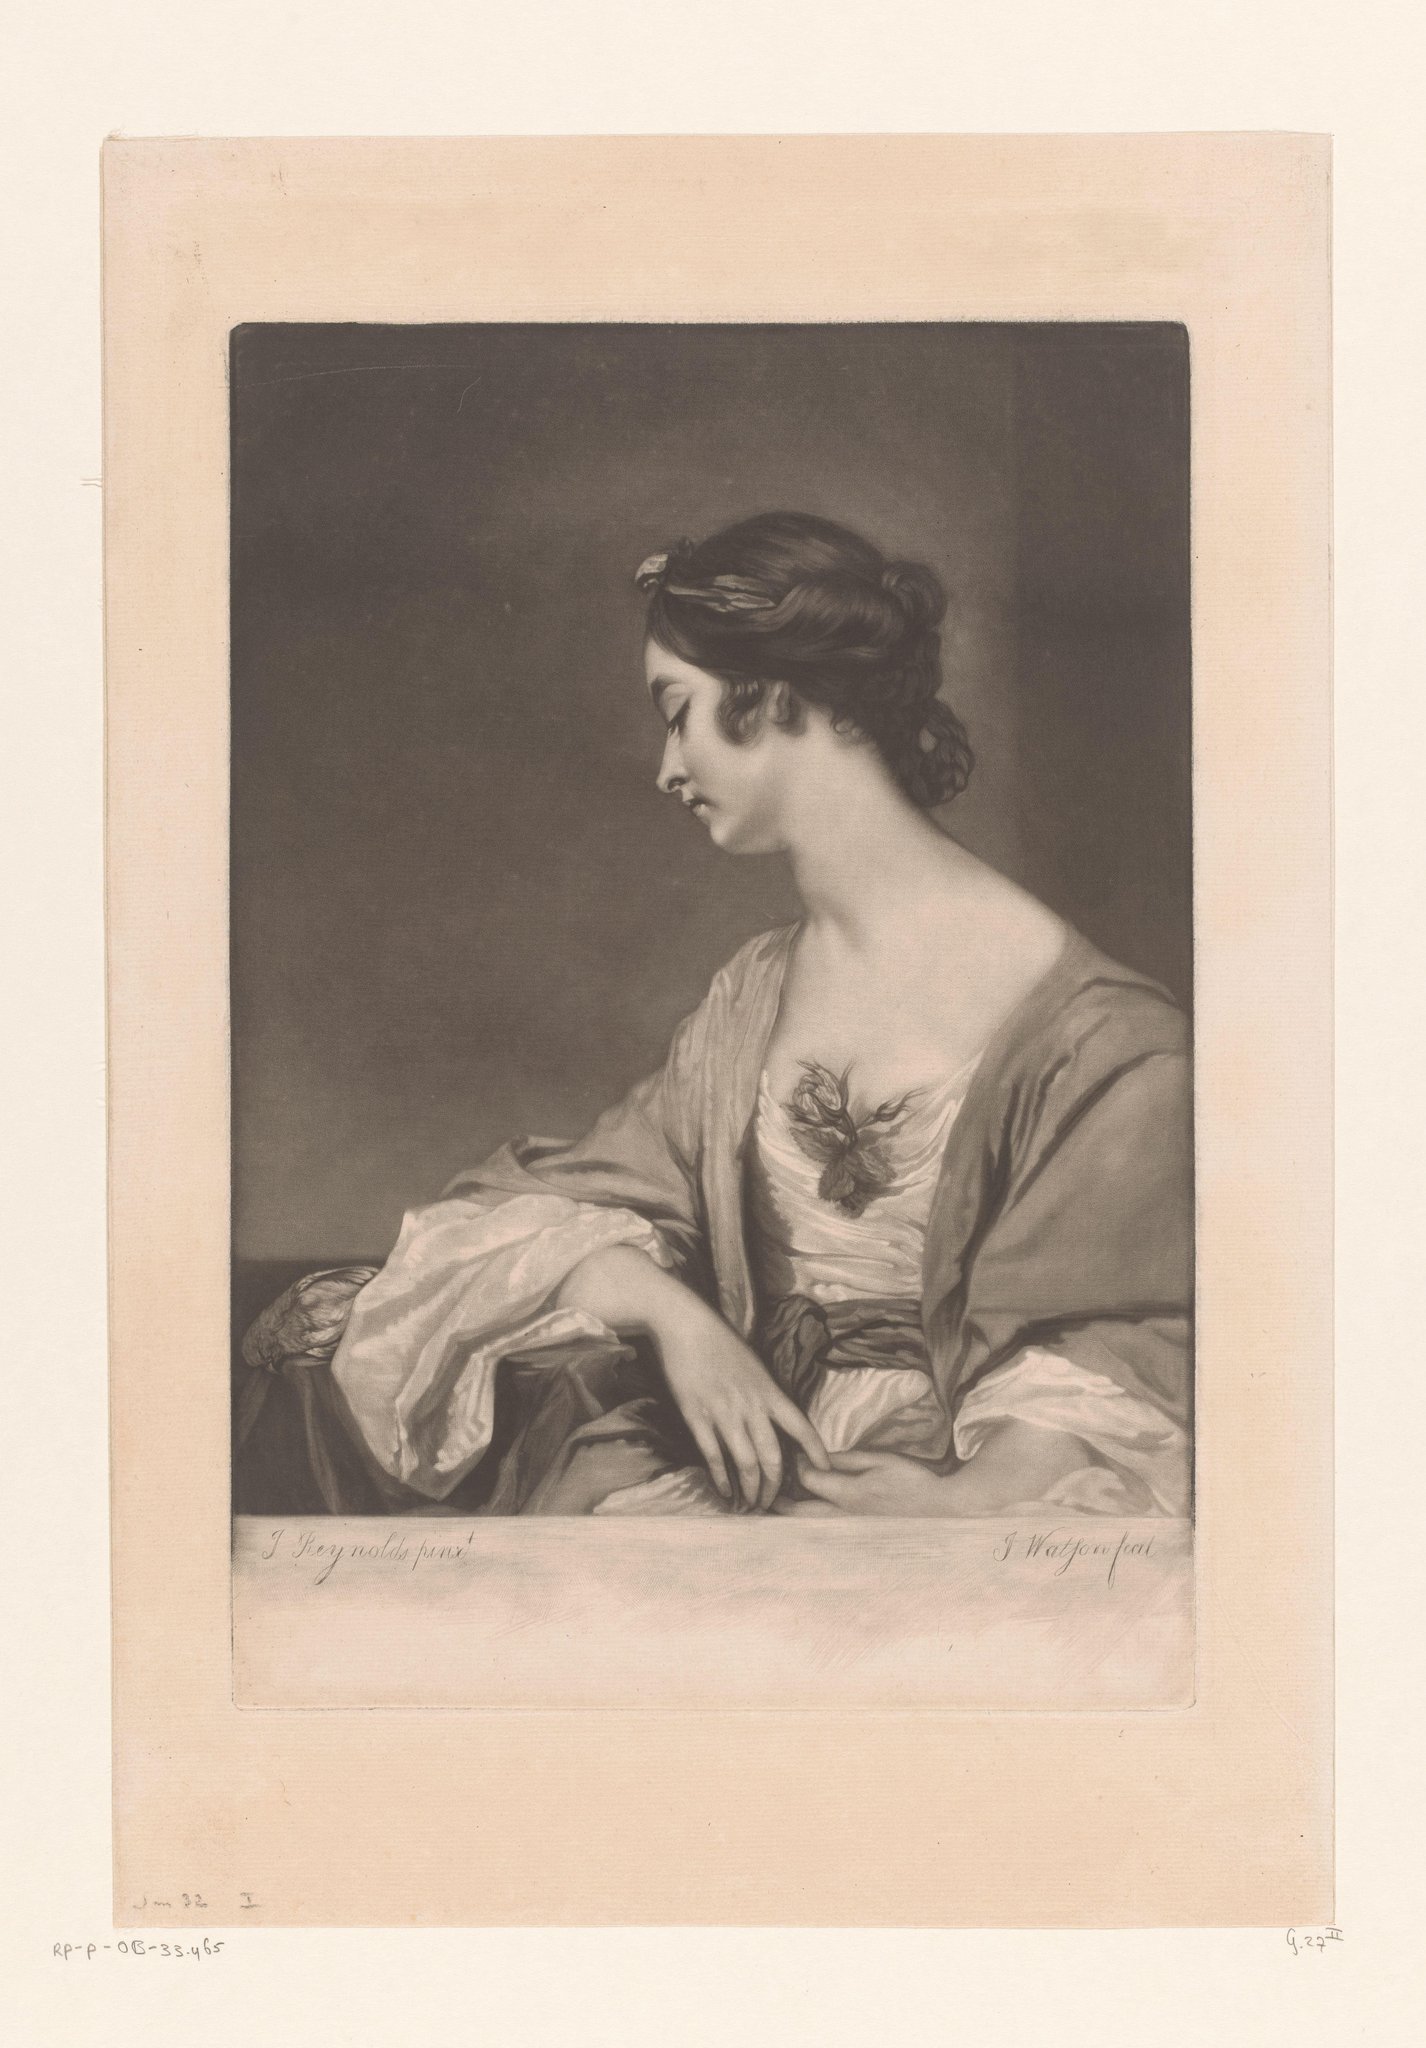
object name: print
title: Portret van Christiana Collier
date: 1764-1770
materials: paper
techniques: mezzotint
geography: london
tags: historical persons - bb - woman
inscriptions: collector's mark: Lugt 240